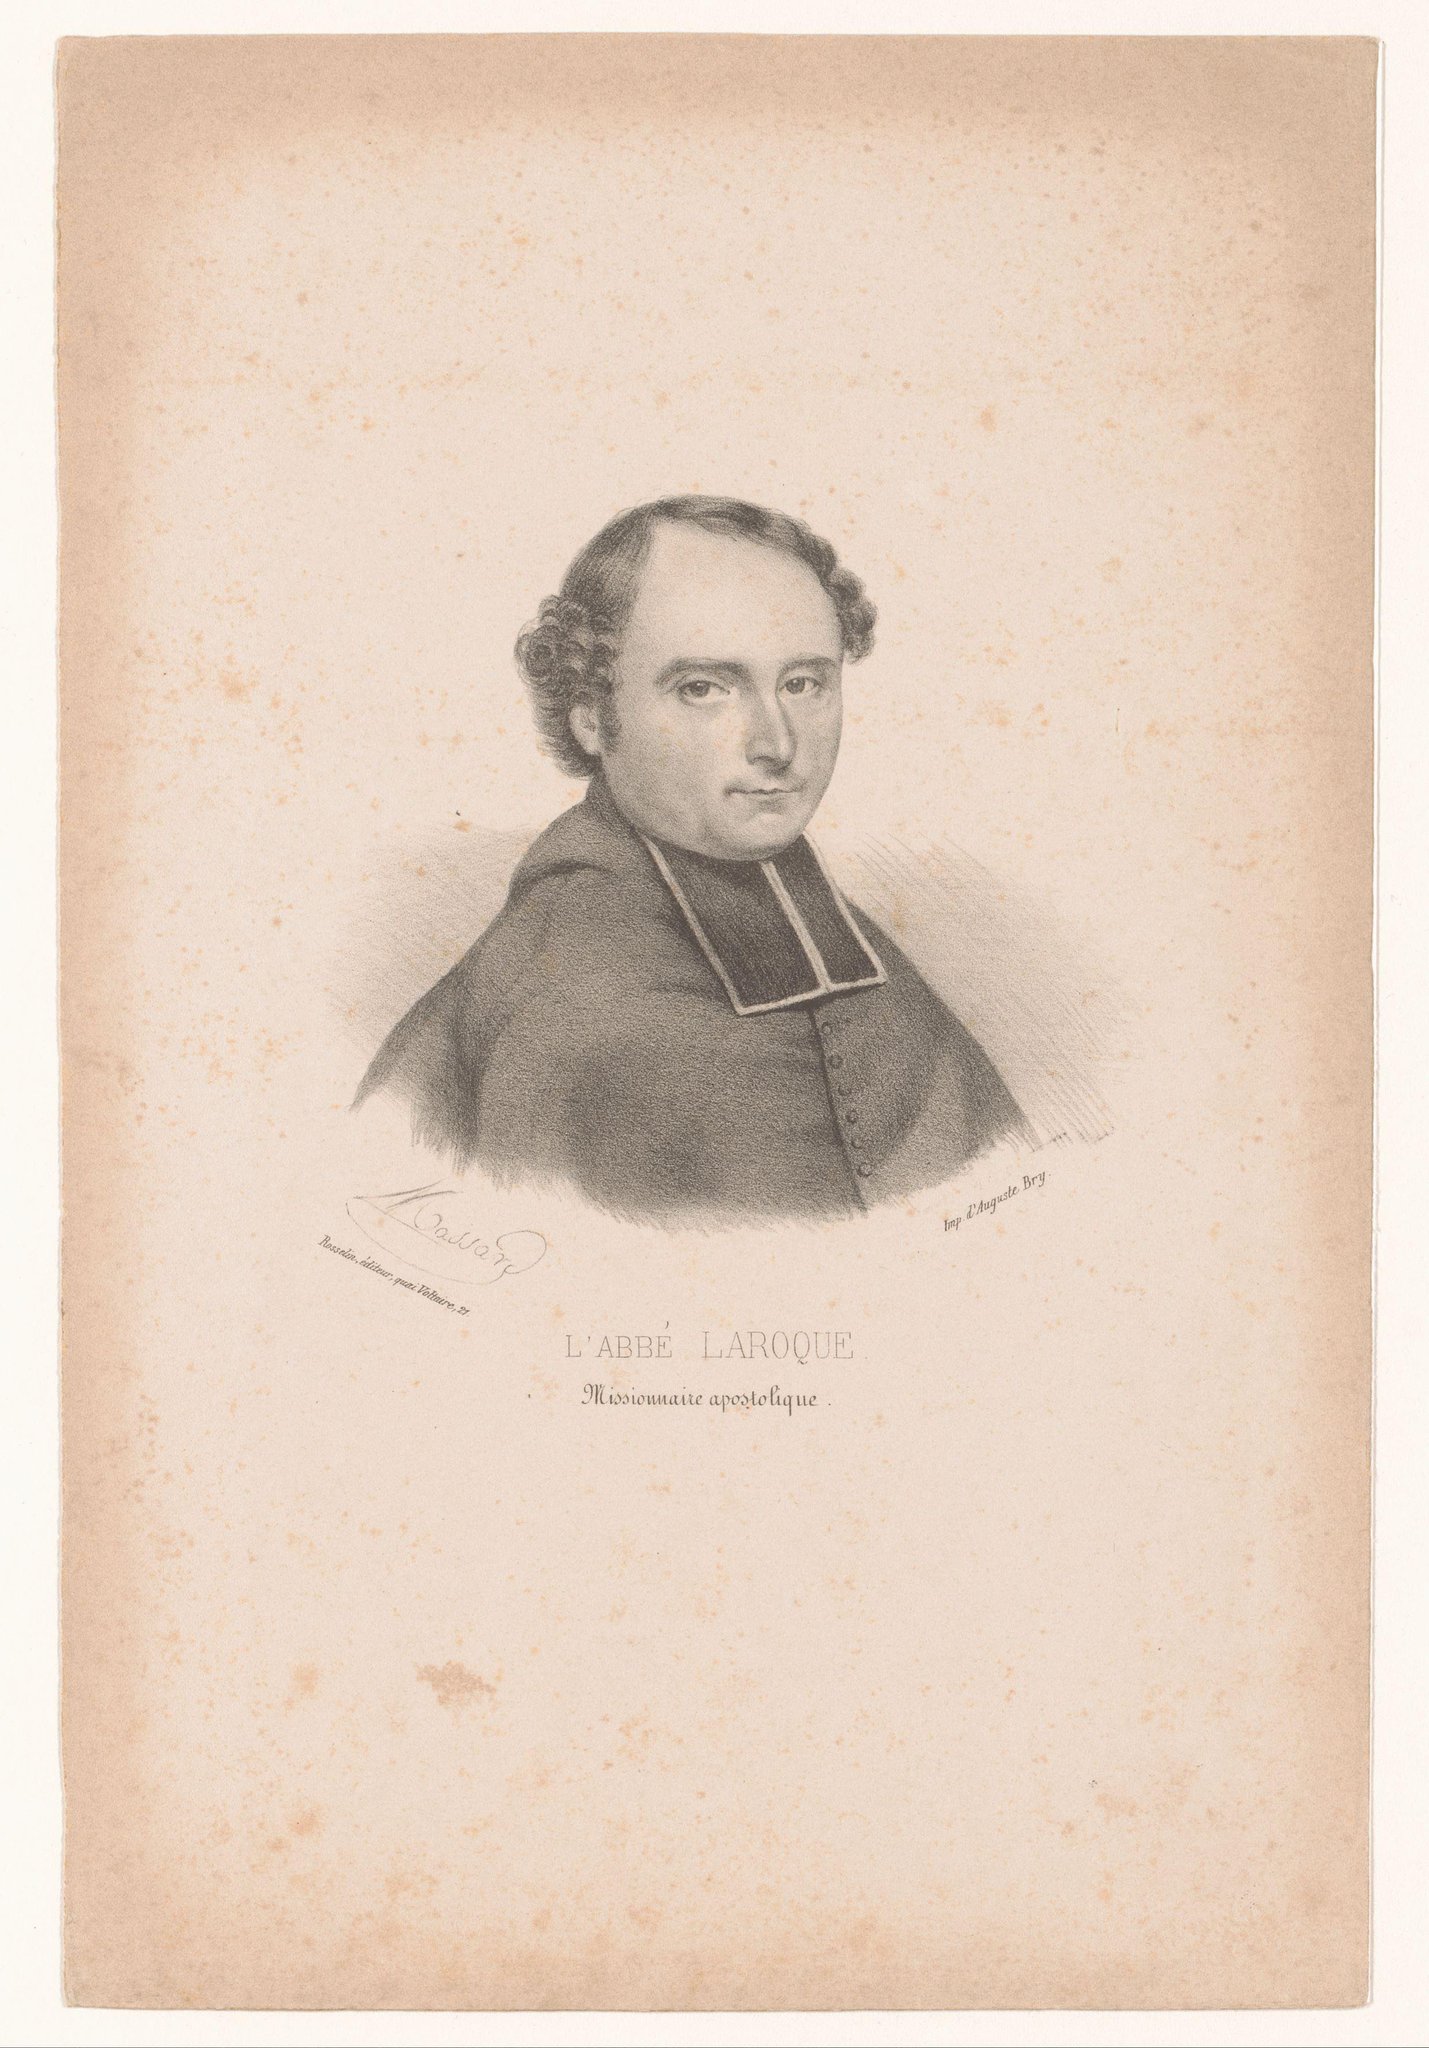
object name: print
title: Portret van abt Bertrand-Martin Laroque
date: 1832-1861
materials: paper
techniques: lithograph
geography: paris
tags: historical persons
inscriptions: collector's mark: Lugt 2228